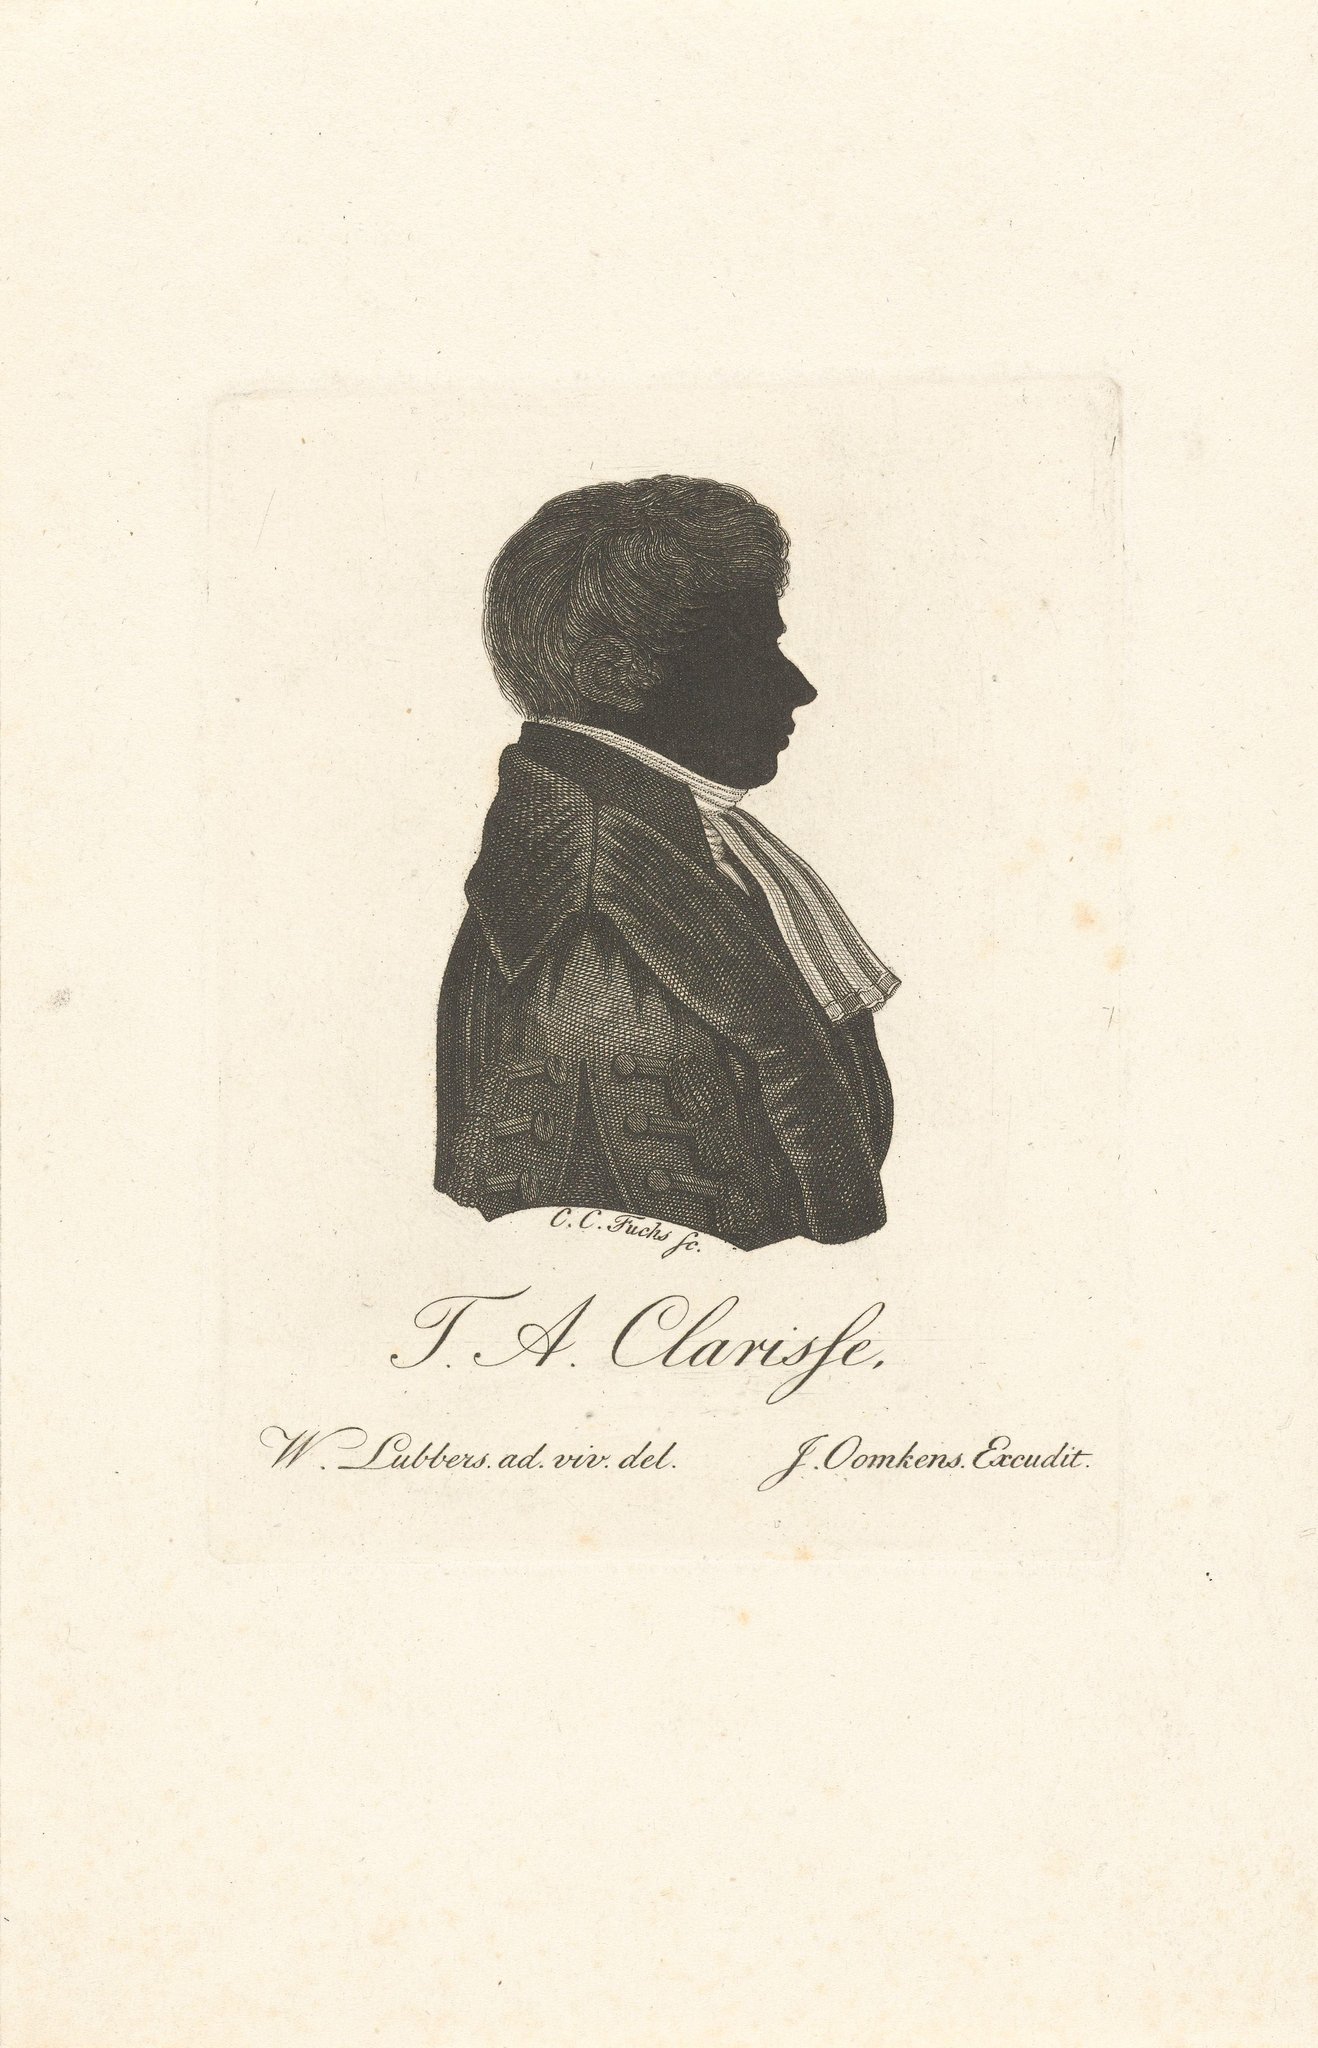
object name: print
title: Silhouetportret van Theodorus Adrianus Clarisse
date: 1808-1844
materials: paper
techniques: etching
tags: amsterdam, leiden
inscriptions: collector's mark: Lugt 2228, collector's mark: Lugt 2760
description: Silhouetportret van Theodorus Adrianus Clarisse, buste naar rechts.